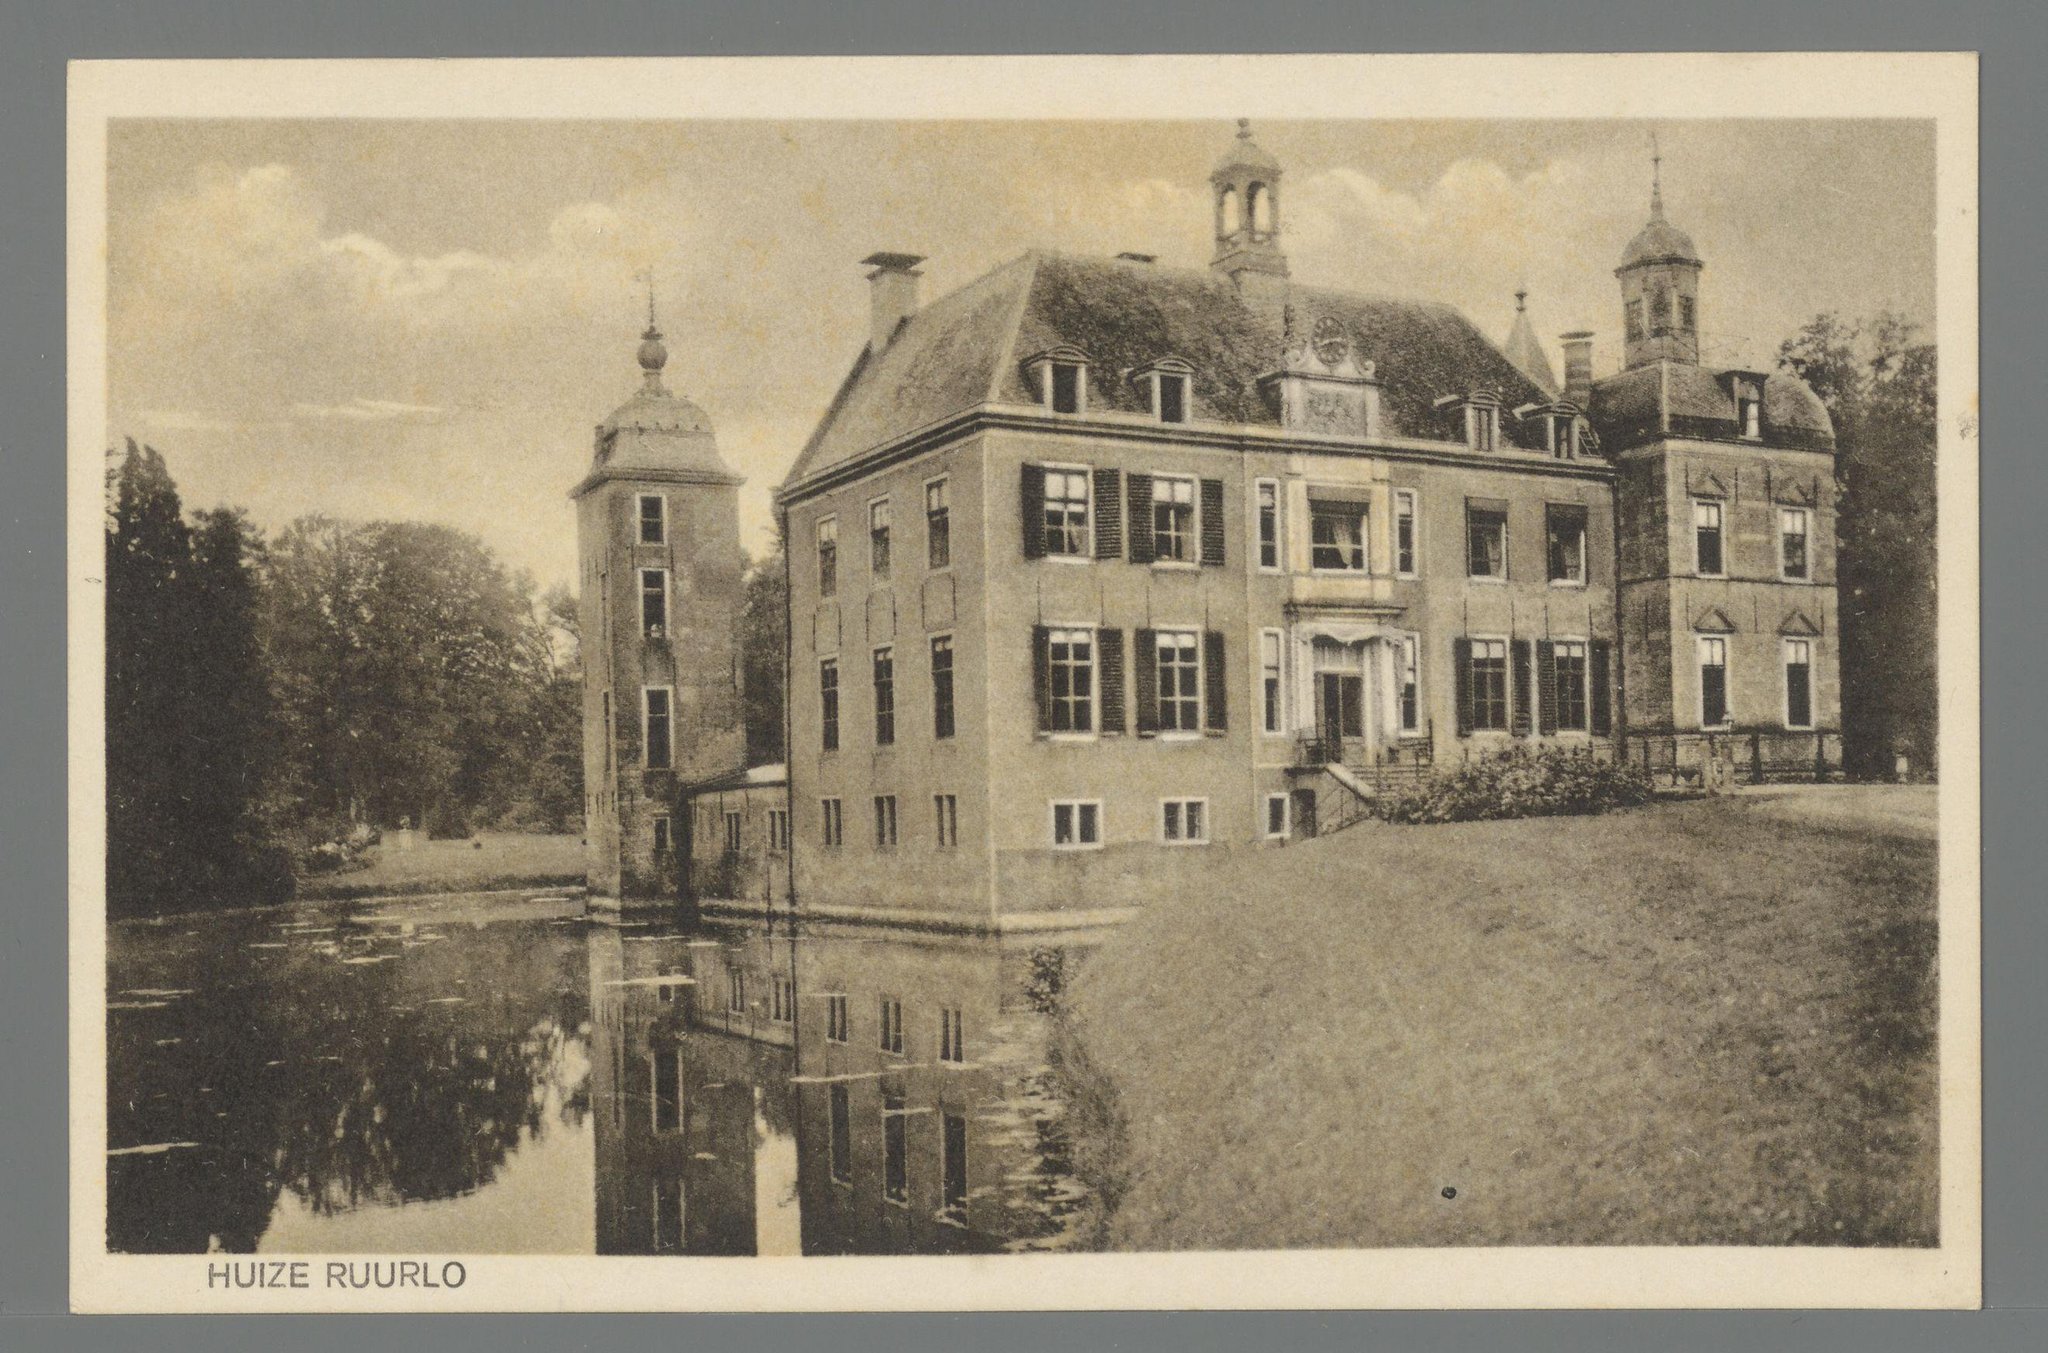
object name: ansichtkaart, prentbriefkaart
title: Huize Ruurlo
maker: Anonymous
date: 1913-1950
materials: cardboard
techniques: photograph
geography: ruurlo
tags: castle, canal